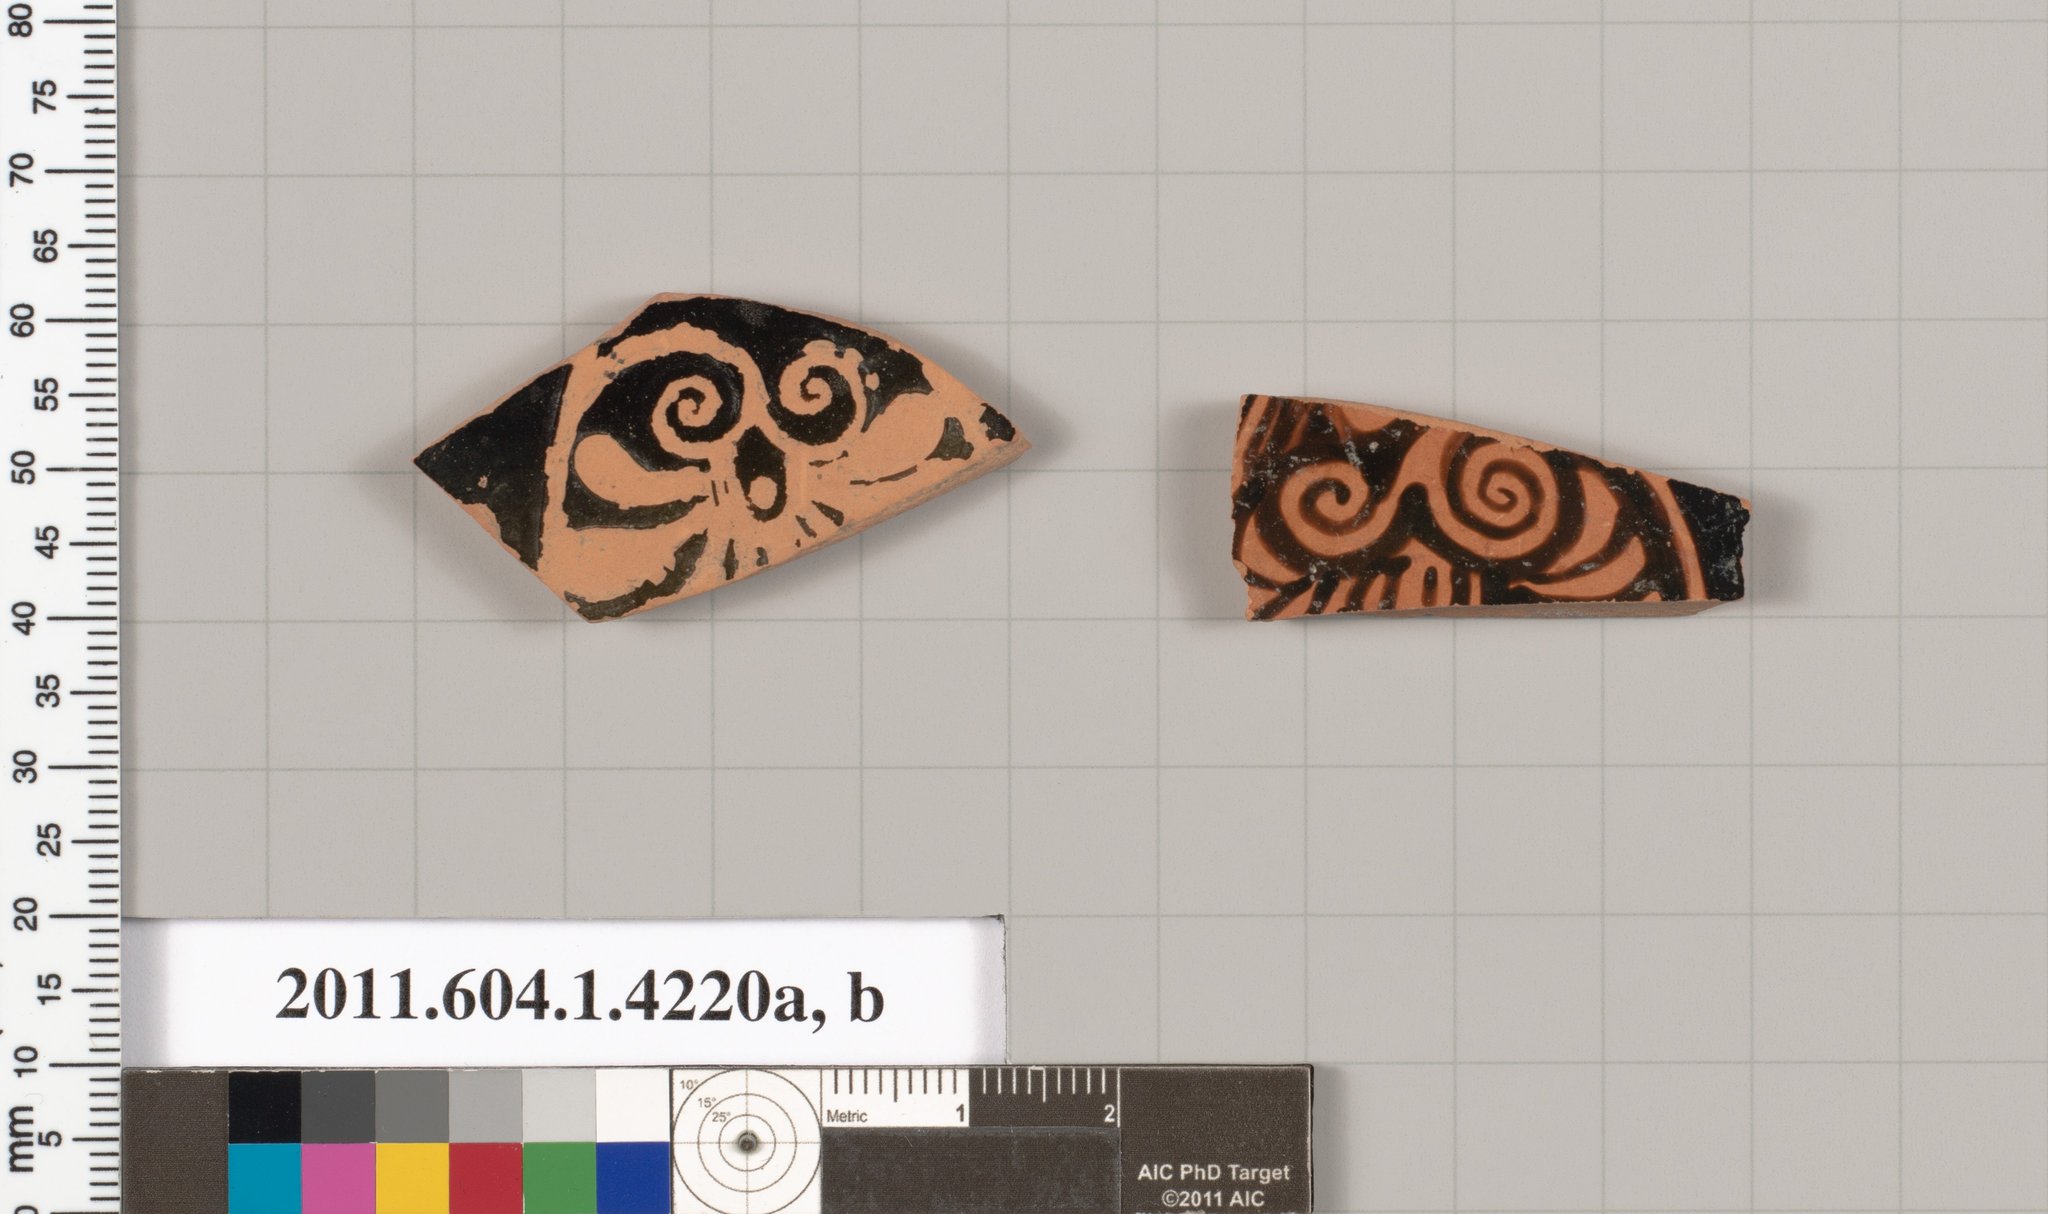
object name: kylix fragment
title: Terracotta fragments of kylikes (drinking cups)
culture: greek, attic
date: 475-451 BCE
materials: terracotta